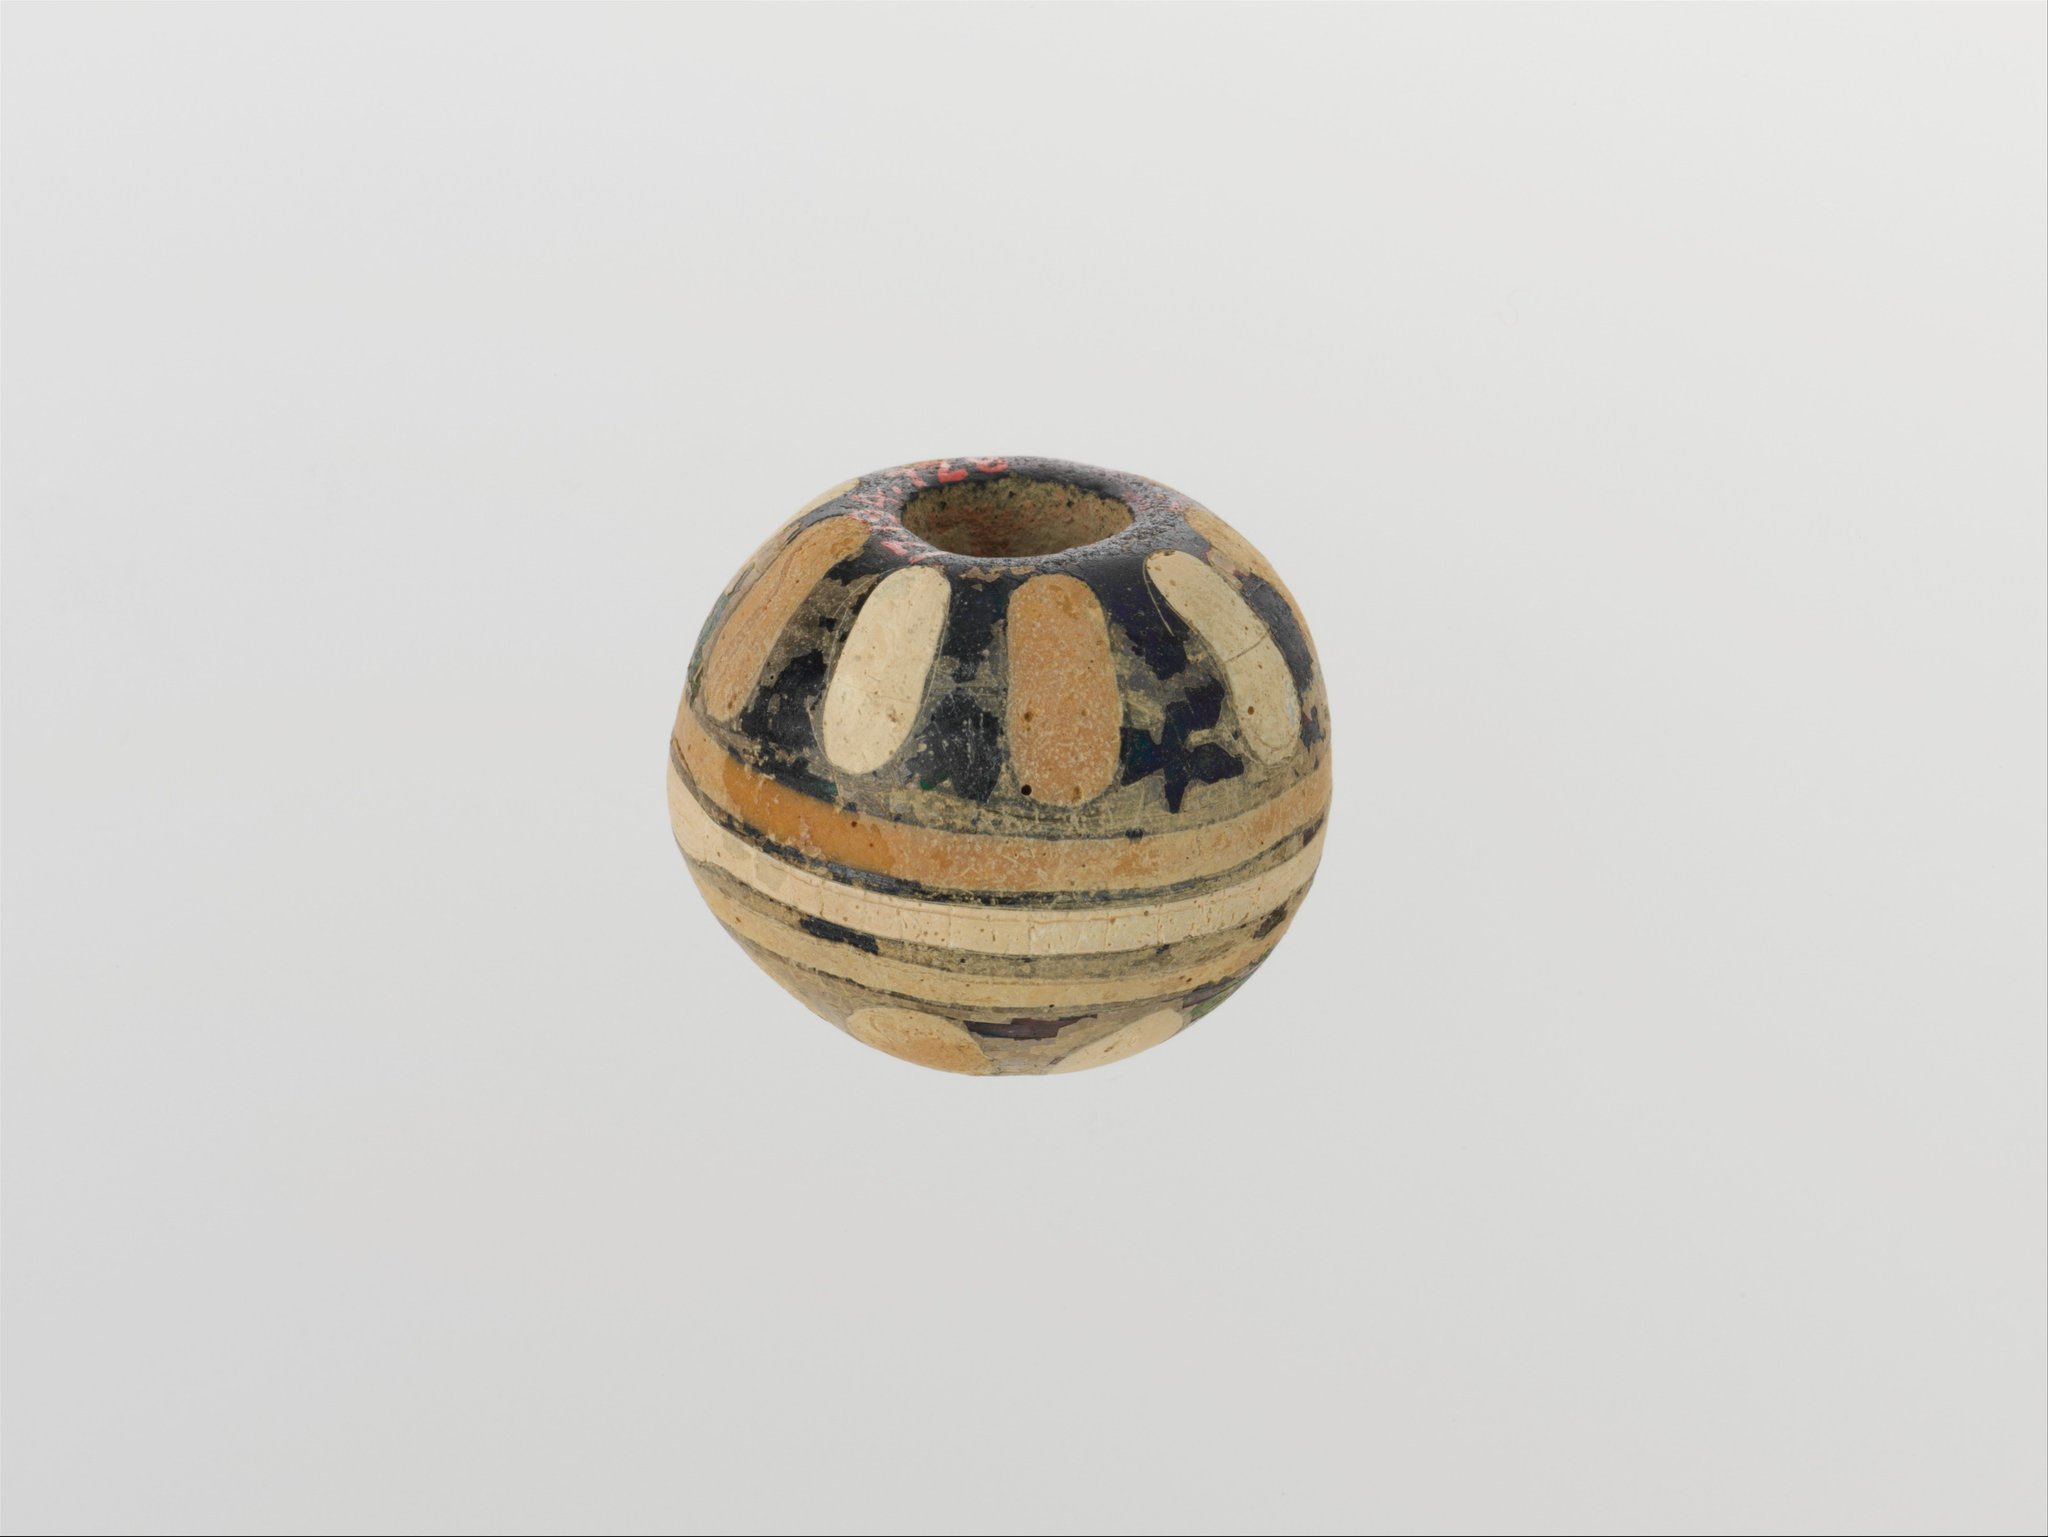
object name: bead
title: Glass bead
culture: carthaginian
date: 350-301 BCE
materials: glass